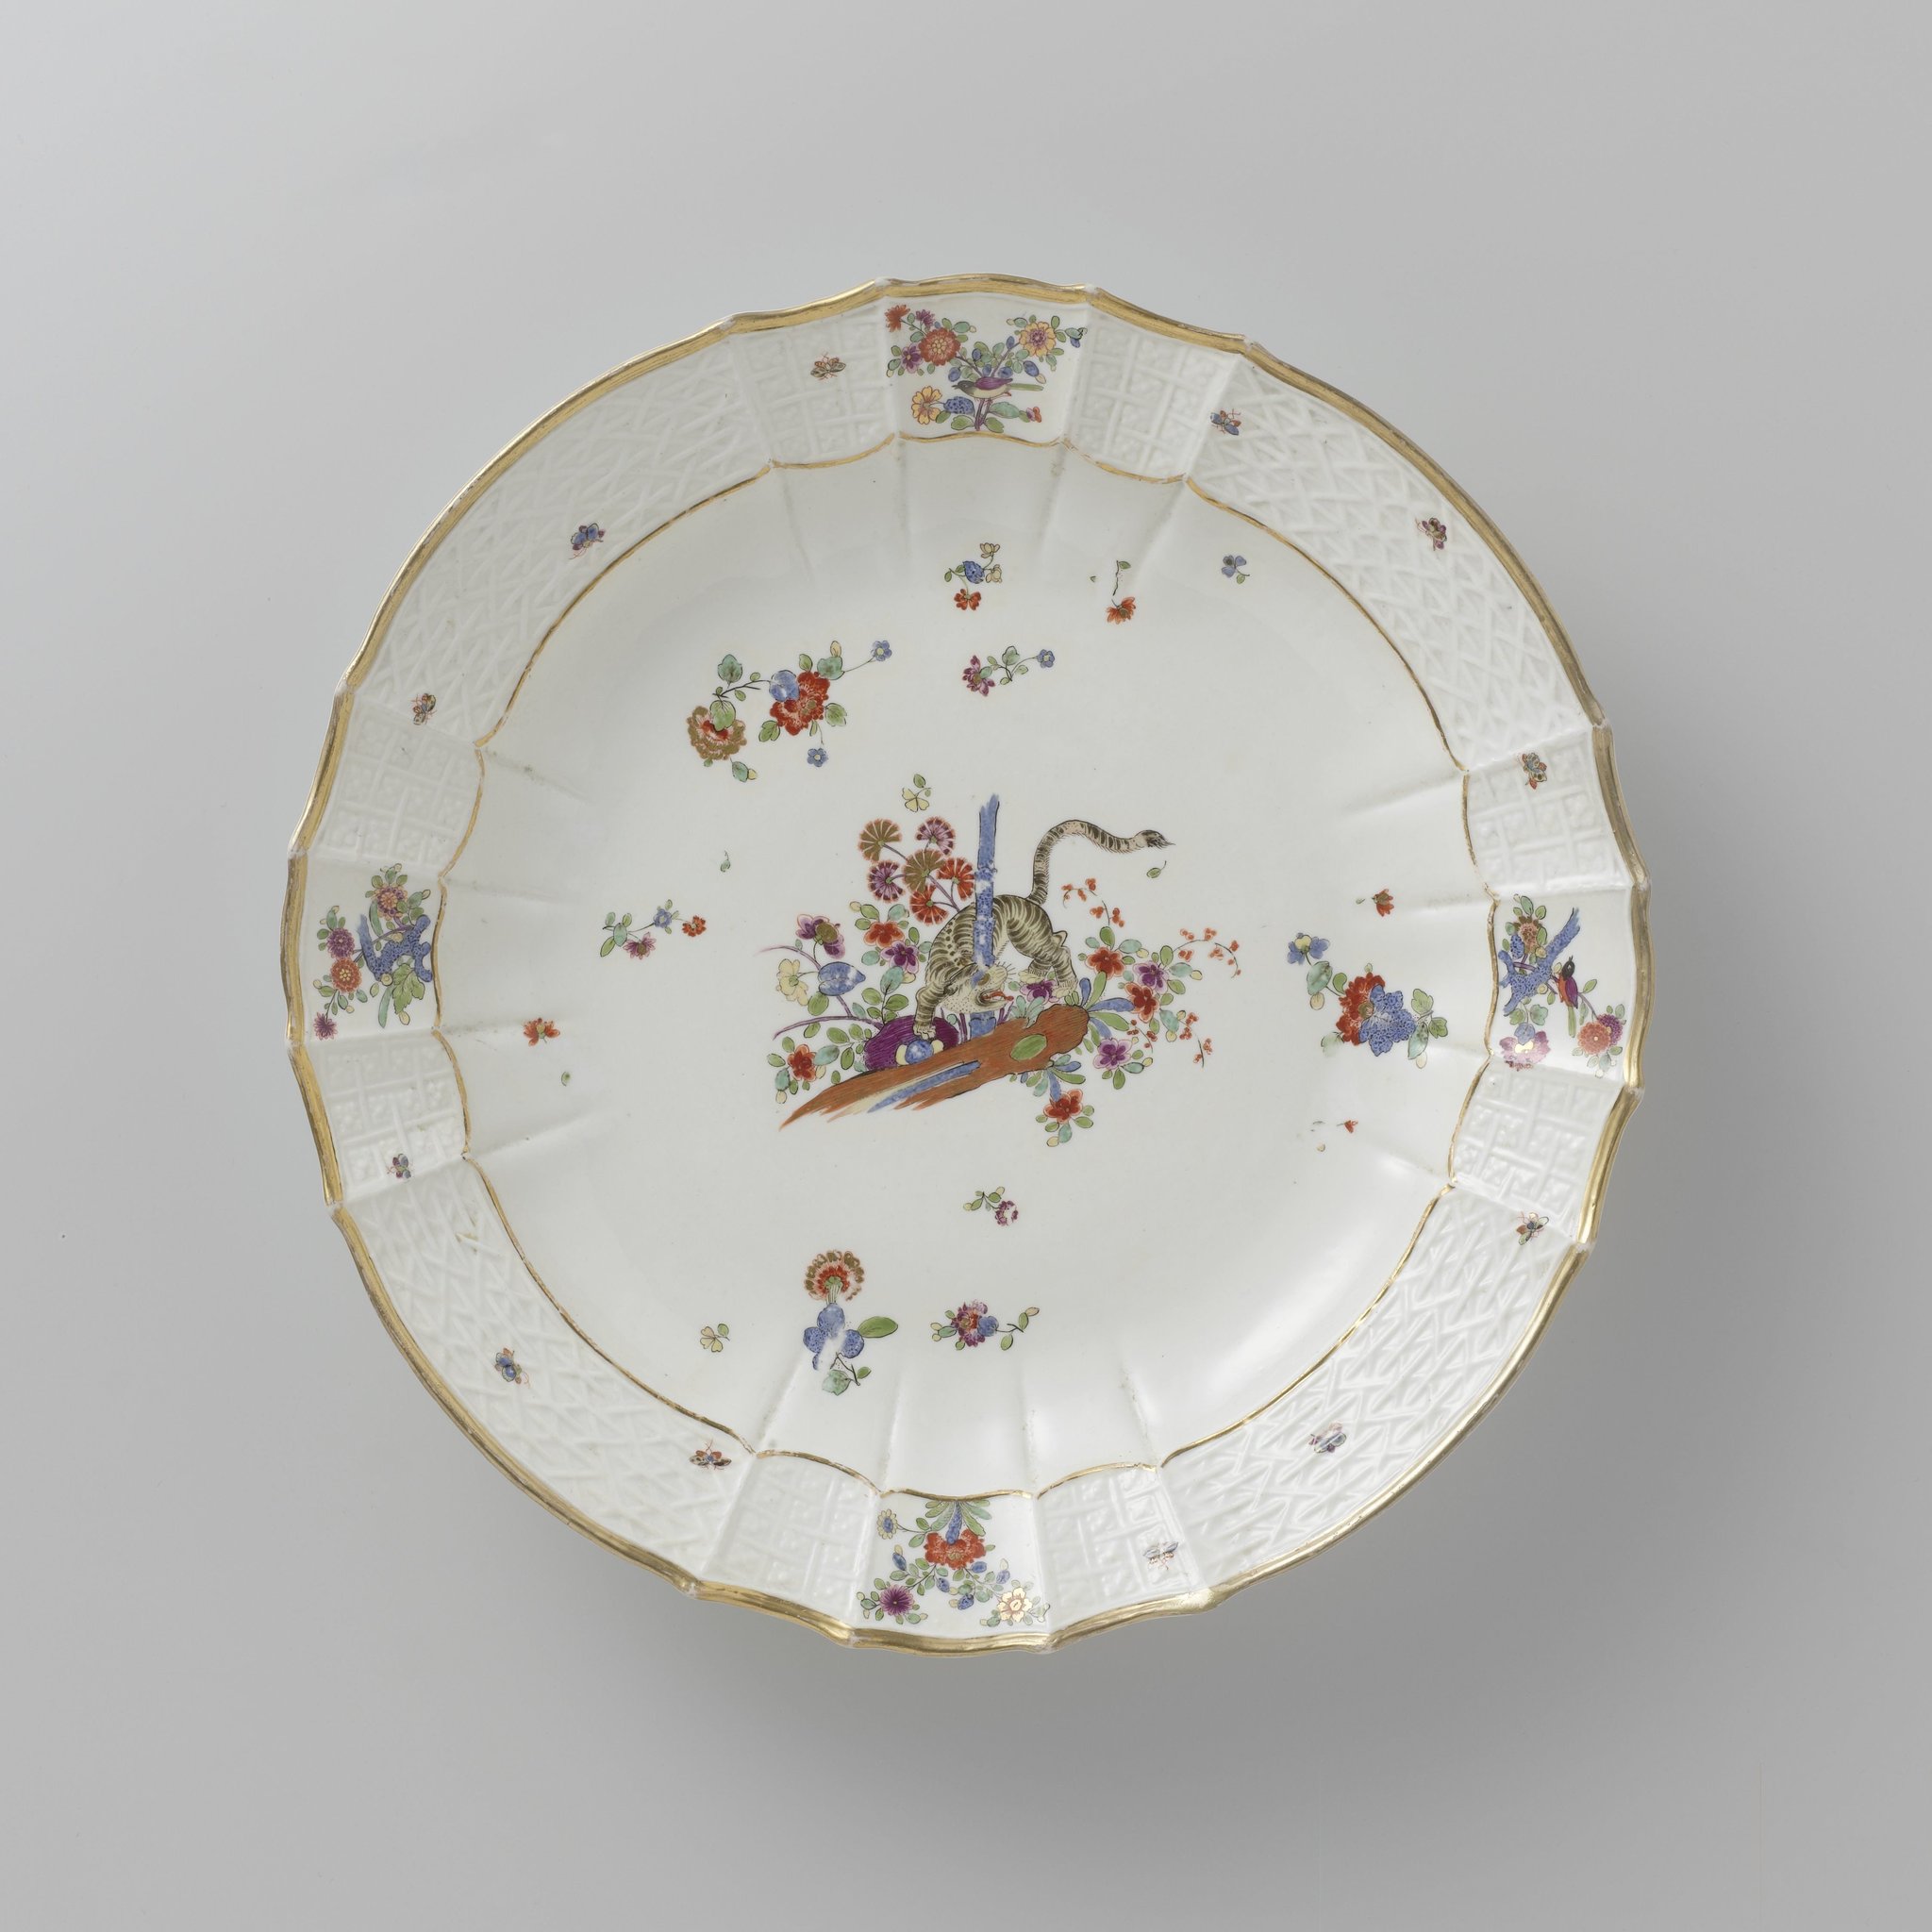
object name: platter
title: Schotel, veelkleurig beschilderd met een Kakiemon-decor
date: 1740-1745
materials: porcelain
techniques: painted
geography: meissen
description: Ronde schotel van beschilderd porselein. De schotel heeft een geribde en geschulpte rand. De schotel is beschilderd met een tijger om een bamboestengel, gestrooide Indianische Blumen, vlinders en takken met vogels. De rand is versierd met het 'Altbrandenstein'-patroon. De schotel is gemerkt.